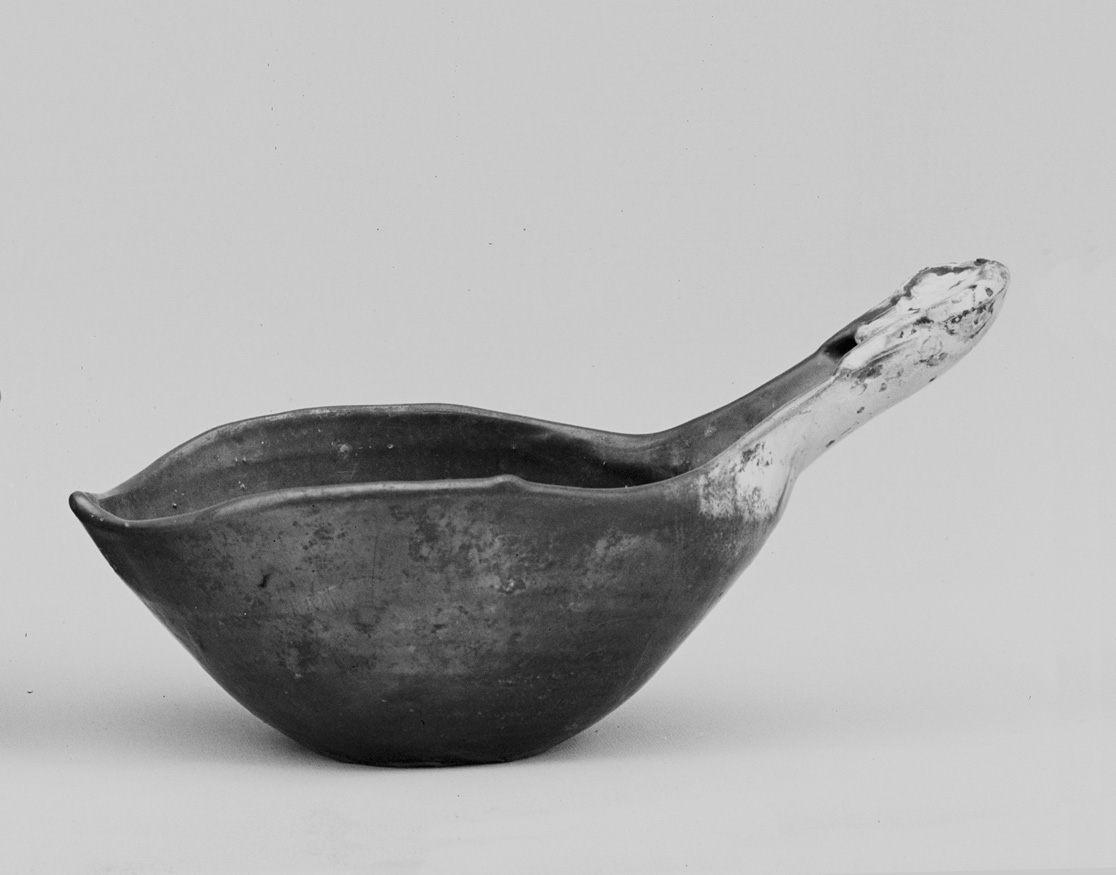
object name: dish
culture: japanese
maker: toyosuke iv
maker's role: artist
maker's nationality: japanese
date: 1840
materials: glaze, pottery